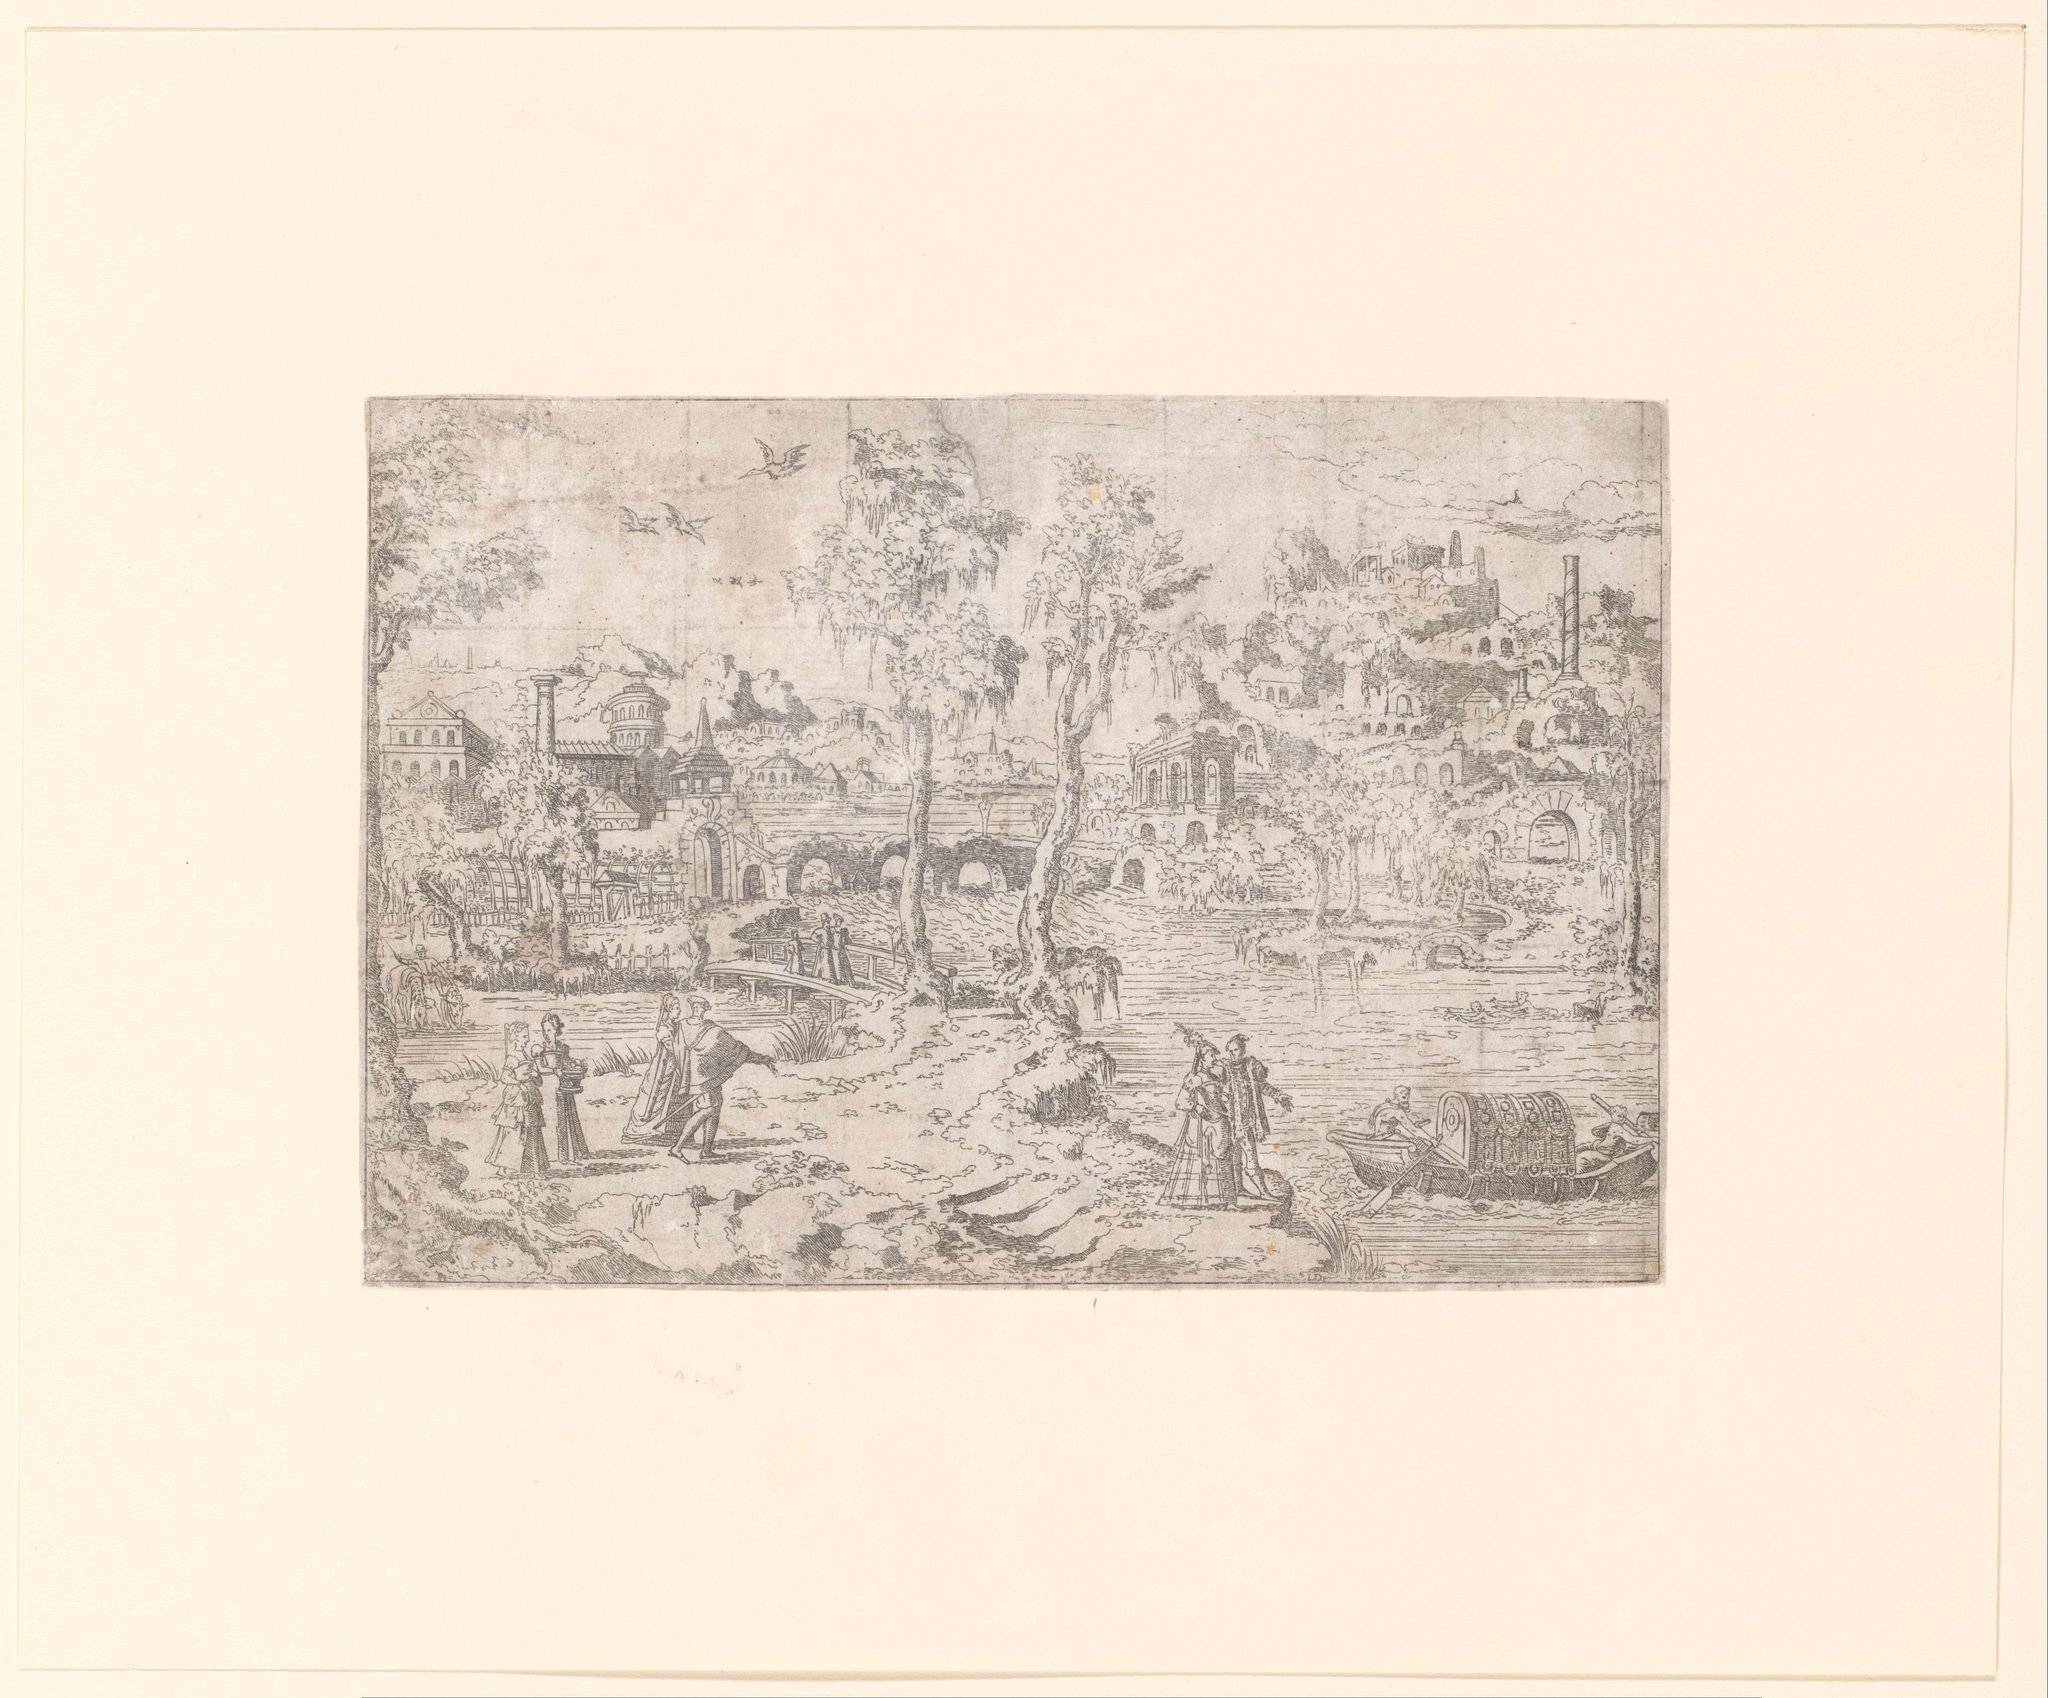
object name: print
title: Hovelingen wandelend door een rivierlandschap met ruïnes en een gondola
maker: léon davent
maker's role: print maker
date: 1540-1556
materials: paper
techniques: etching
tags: landscapes with waters, waterscapes, seascapes (in the temperate zone), royal household; courtiers, retinue, train, gondola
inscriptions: collector's mark: Lugt 2760, collector's mark: Lugt 2228